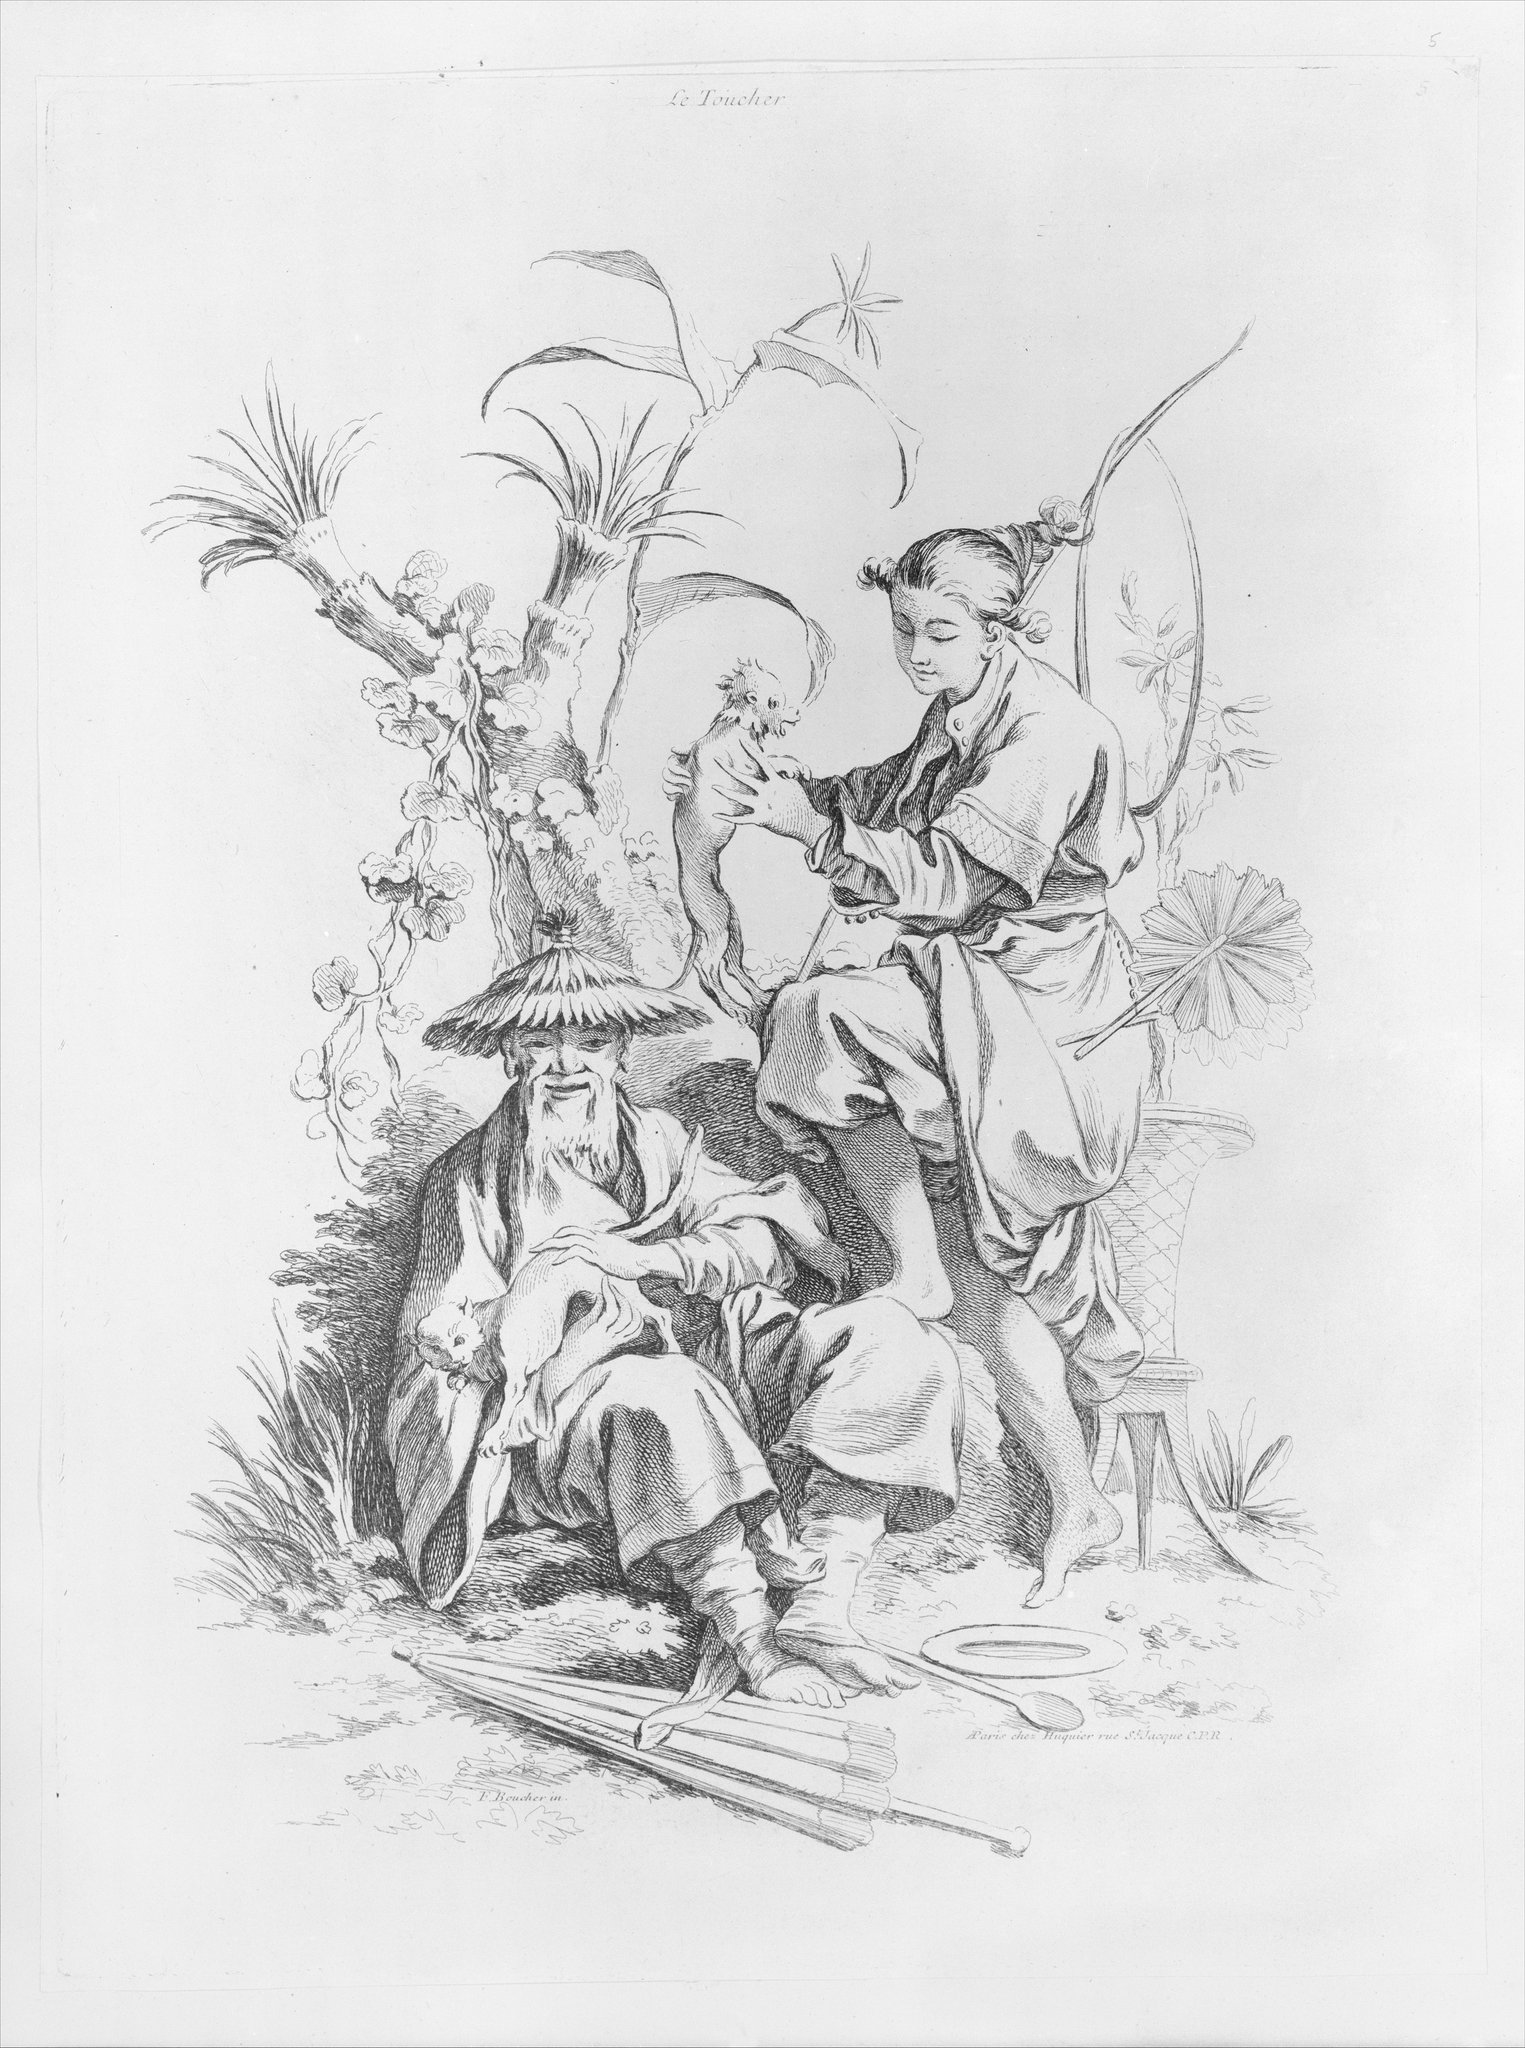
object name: print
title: The Five Senses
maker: françois boucher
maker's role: artist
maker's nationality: french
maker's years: 1703-1770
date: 1720-1770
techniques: engraving, etching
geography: france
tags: chinoiserie,women,cats